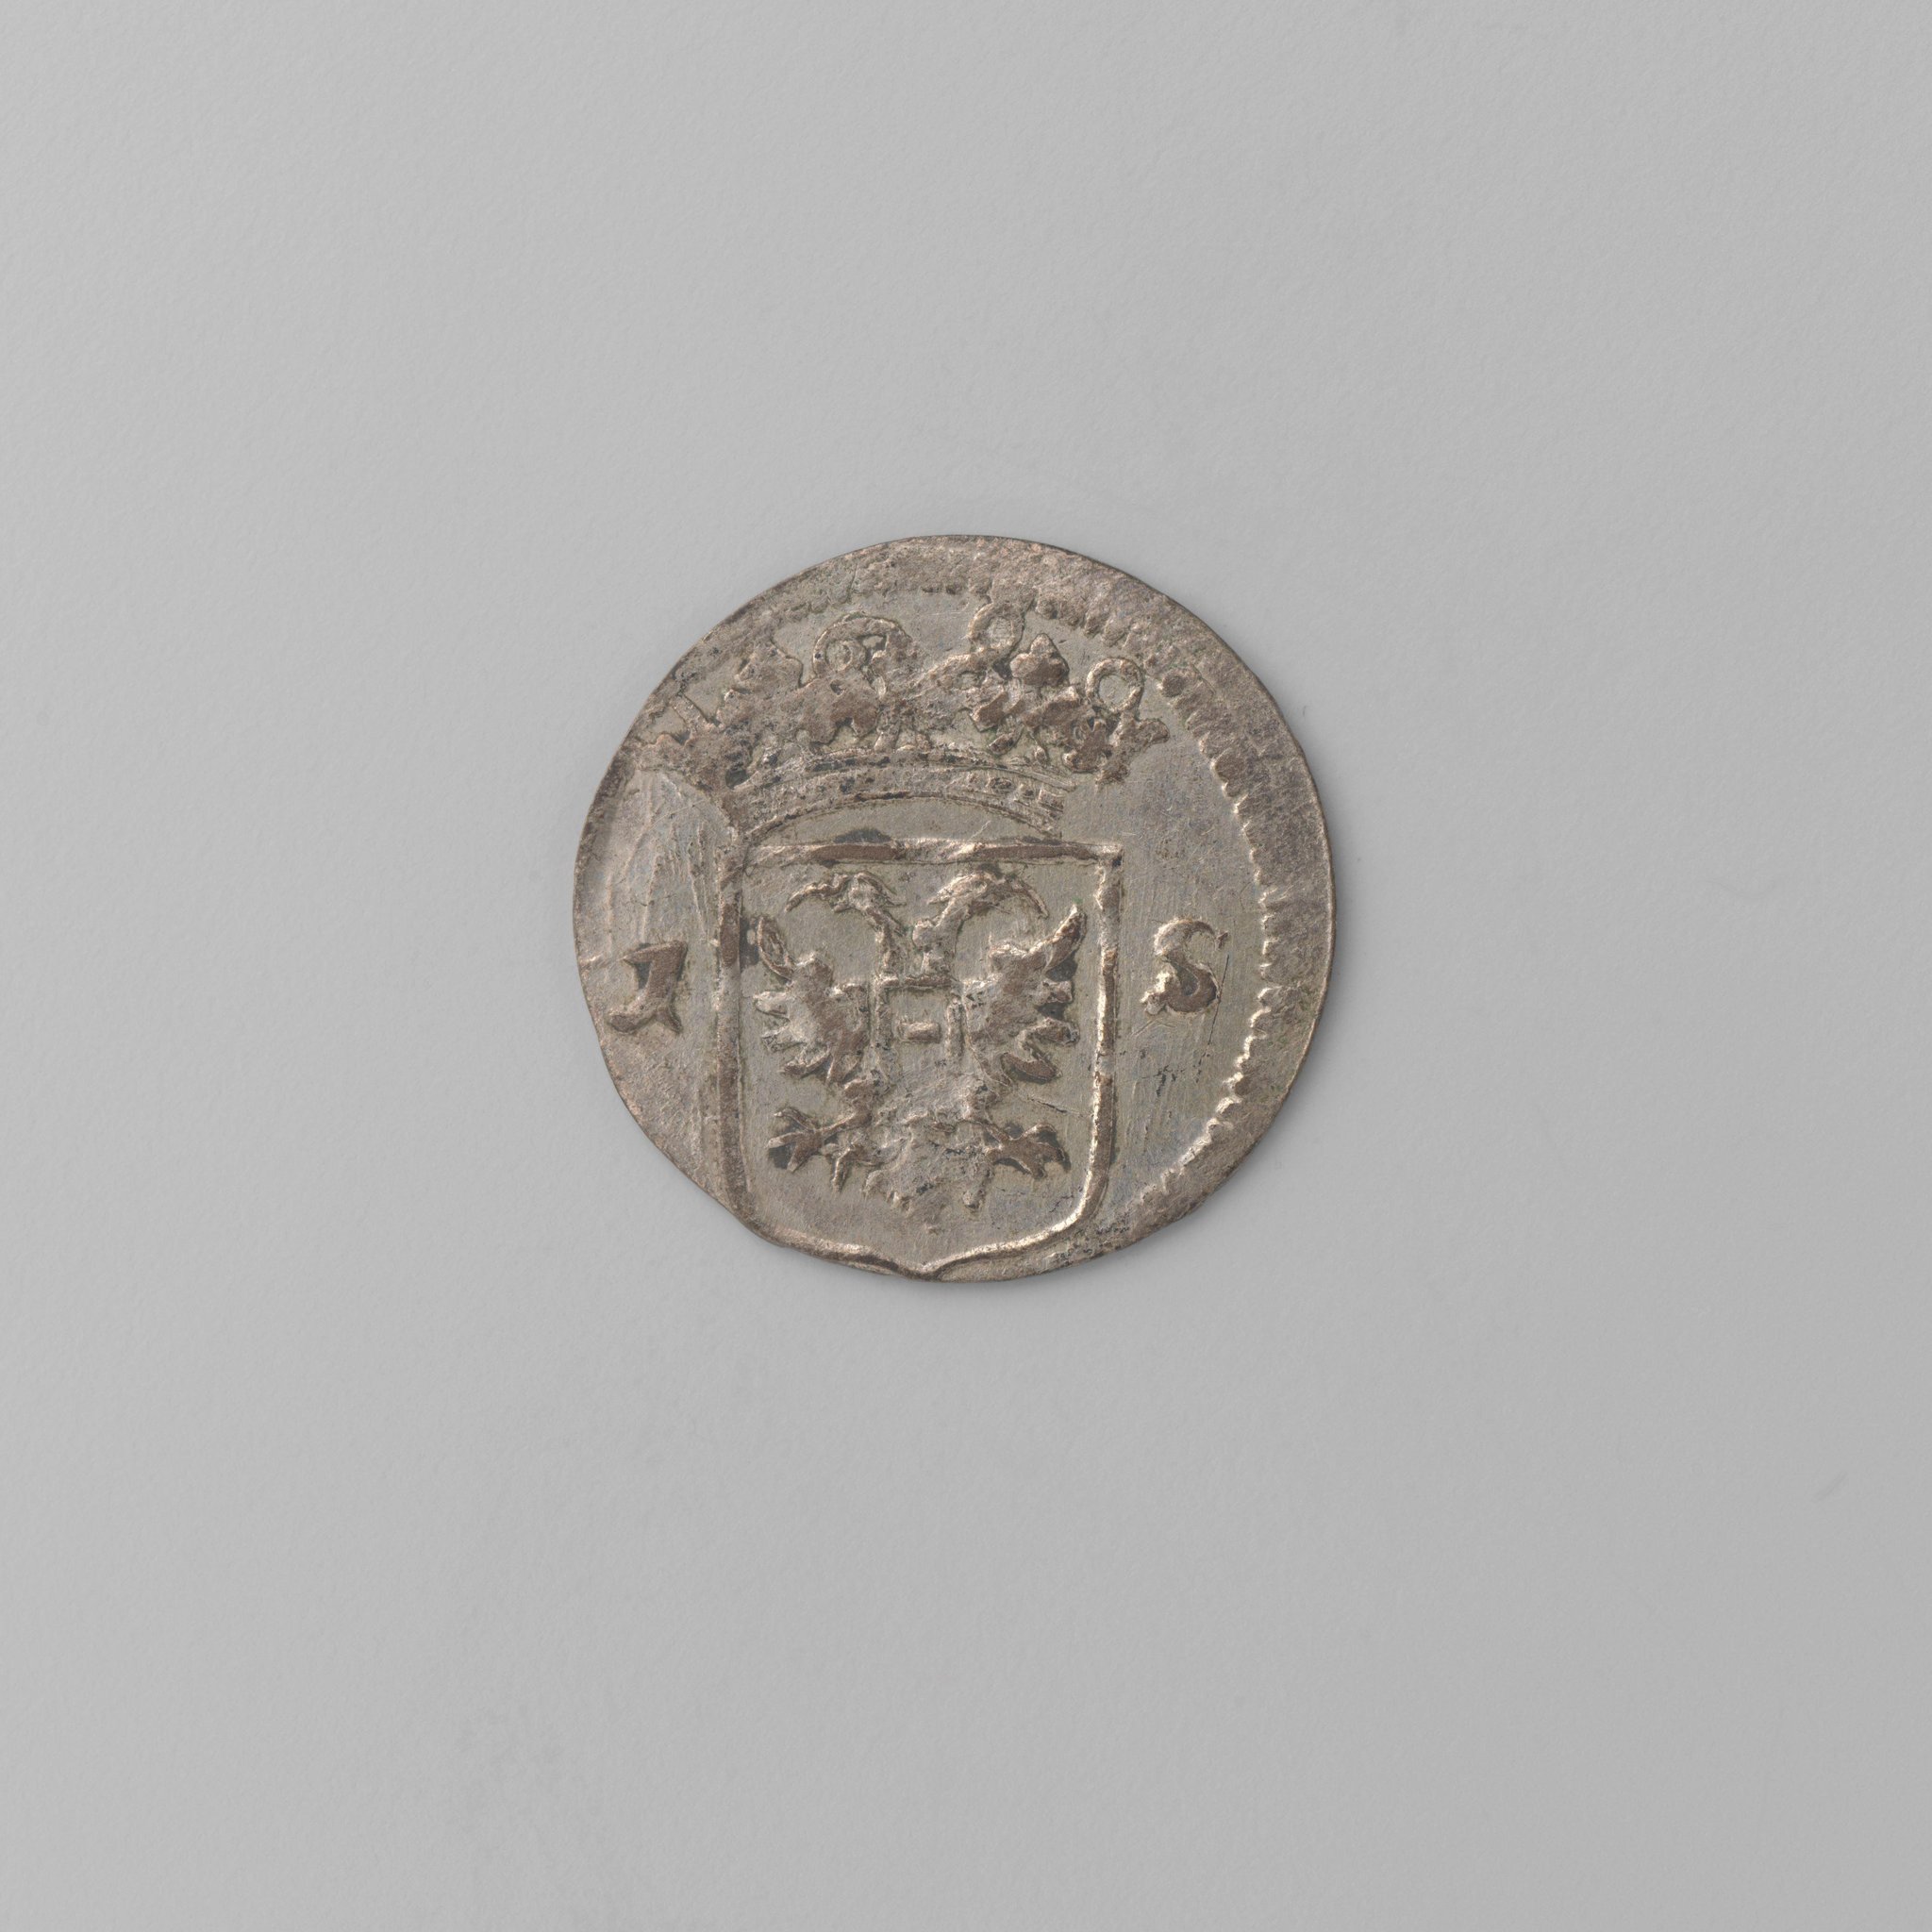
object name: coin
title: Stuiver van Groningen, 1690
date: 1690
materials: silver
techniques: striking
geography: groningen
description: Zilveren munt. Voorzijde: tussen waarde-aanduiding I S gekrooond wapenschild. Jaartal boven kroon. Keerzijde: drie-regelig opschrift: CIV/GRONIN/GA.